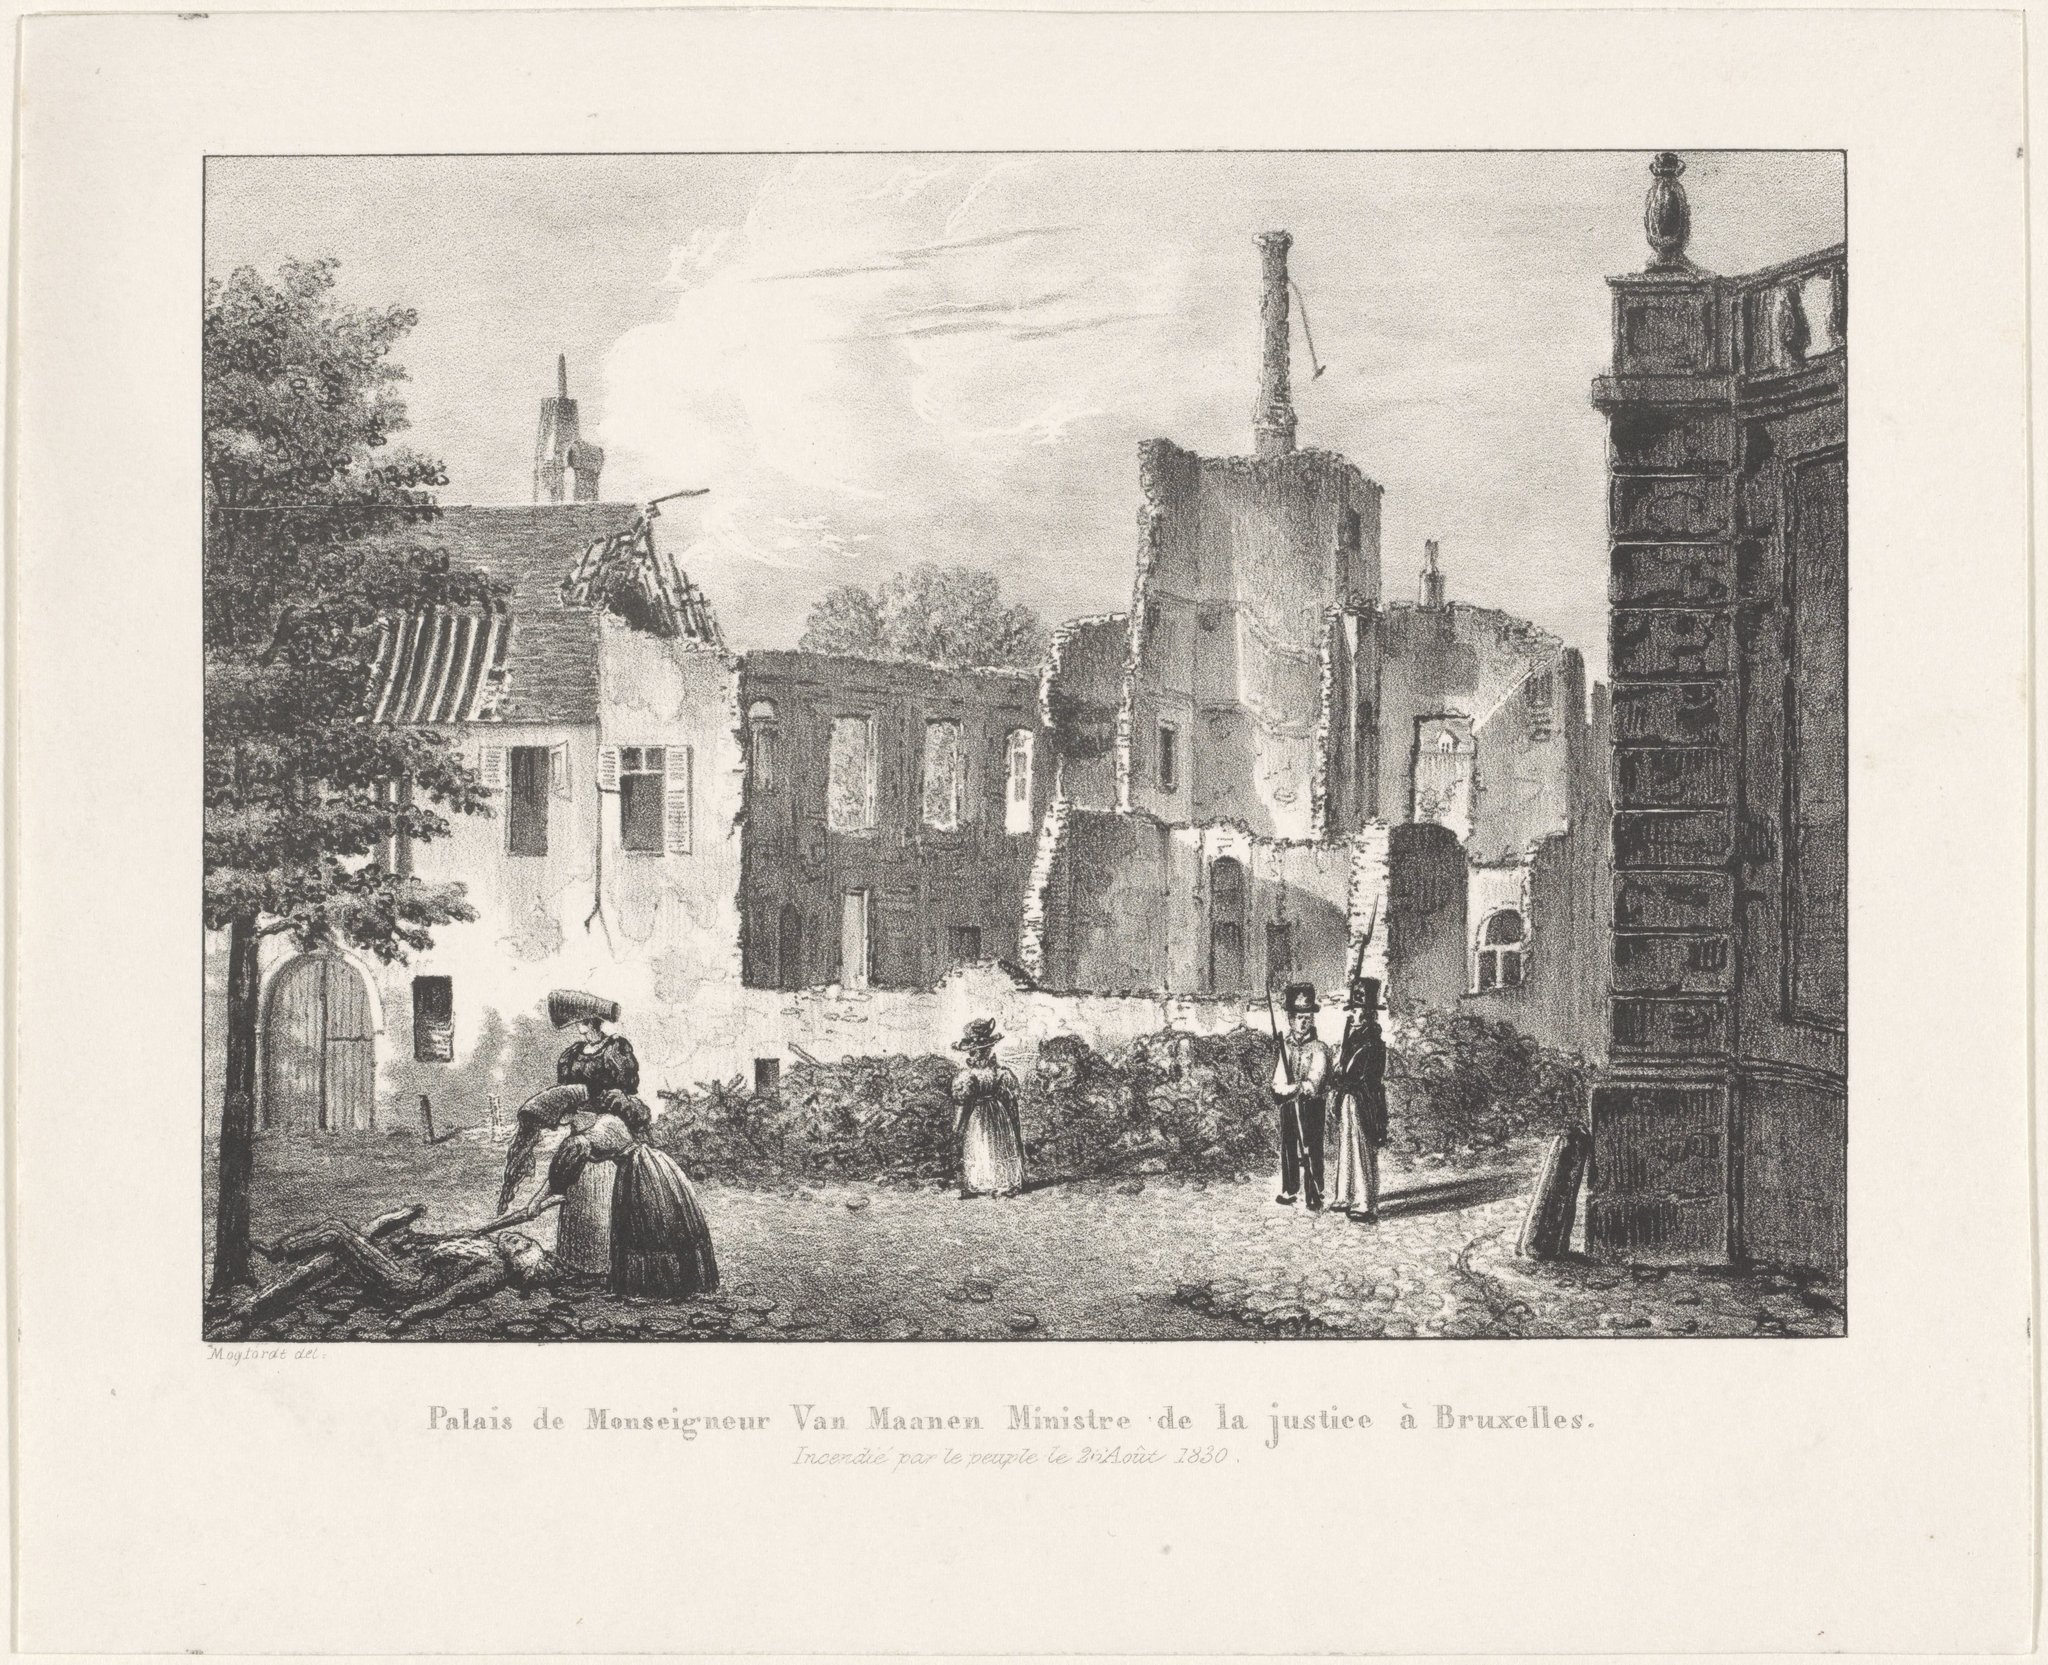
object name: print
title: Palais de Monseigneur Van Maanen Ministre de la justice à Bruxelles. Incendié par le peuple le 26 Août 1830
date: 1830-1831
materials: paper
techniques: lithograph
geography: belgium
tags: devastated, ruined place or city (~ warfare), street-fights, riots, brussels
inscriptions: collector's mark: Lugt 2228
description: Ruïne van het uitgebrande huis van Cornelis Felix van Maanen, minister van Justitie, in Brussel. In brand gestoken door het volk op 26 augustus 1830. Onderdeel van een groep van prenten uit verschillende andere series verwant aan de platen in het recueil over de gebeurtenissen tijdens de Belgische Revolutie in Brussel, Antwerpen en andere steden in de periode 25 augustus 1830 tot 27 maart 1831.